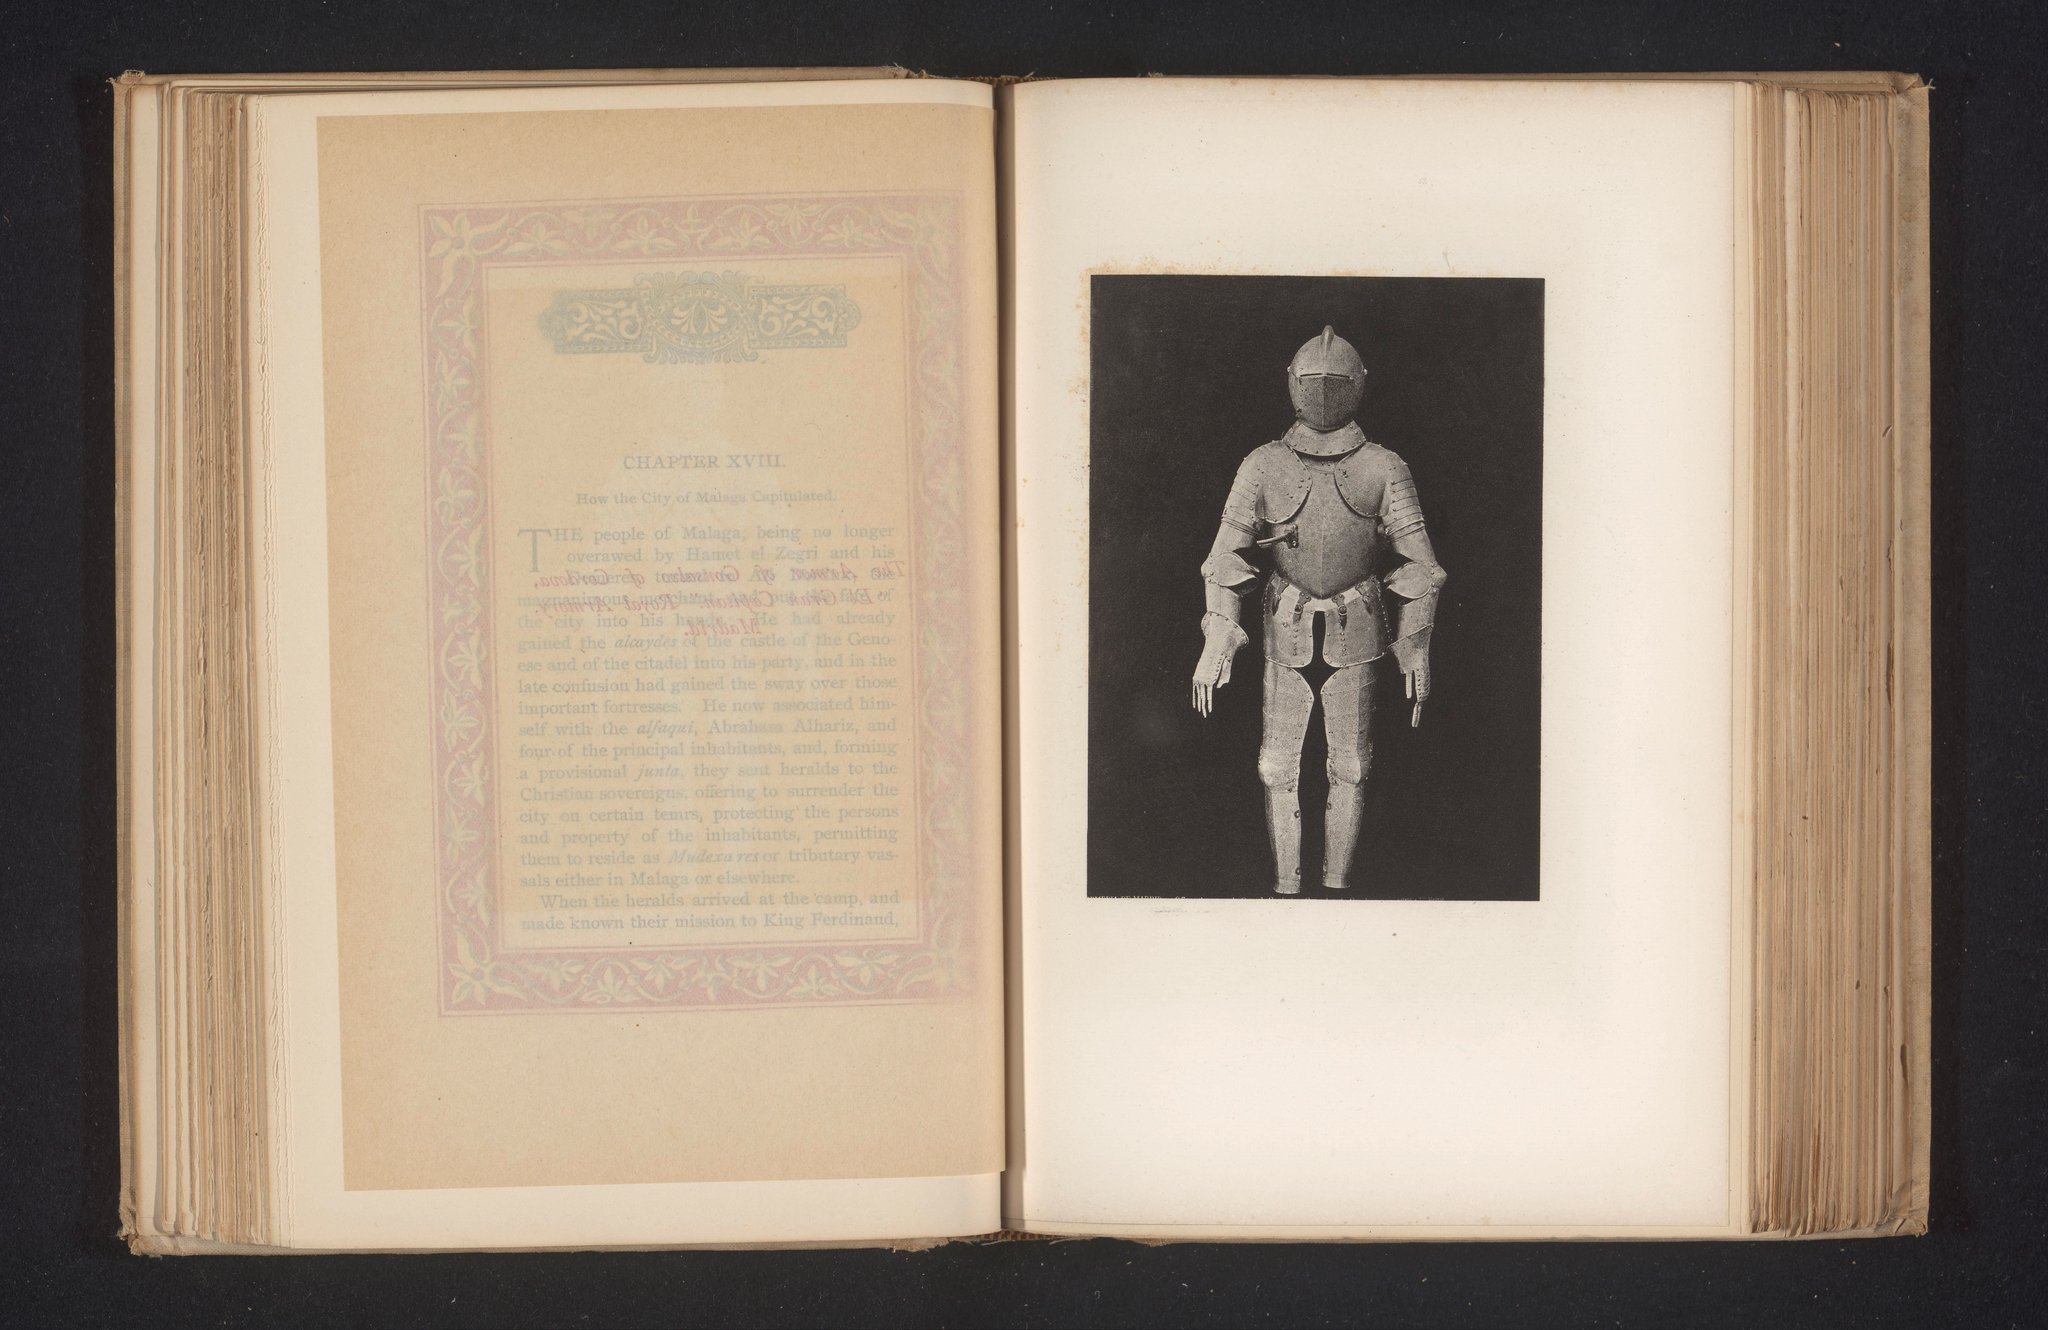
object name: photomechanical print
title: Harnas van Gonzalo Fernández de Córdoba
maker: Anonymous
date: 1883-1893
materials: paper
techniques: photoaquatint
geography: madrid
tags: armour